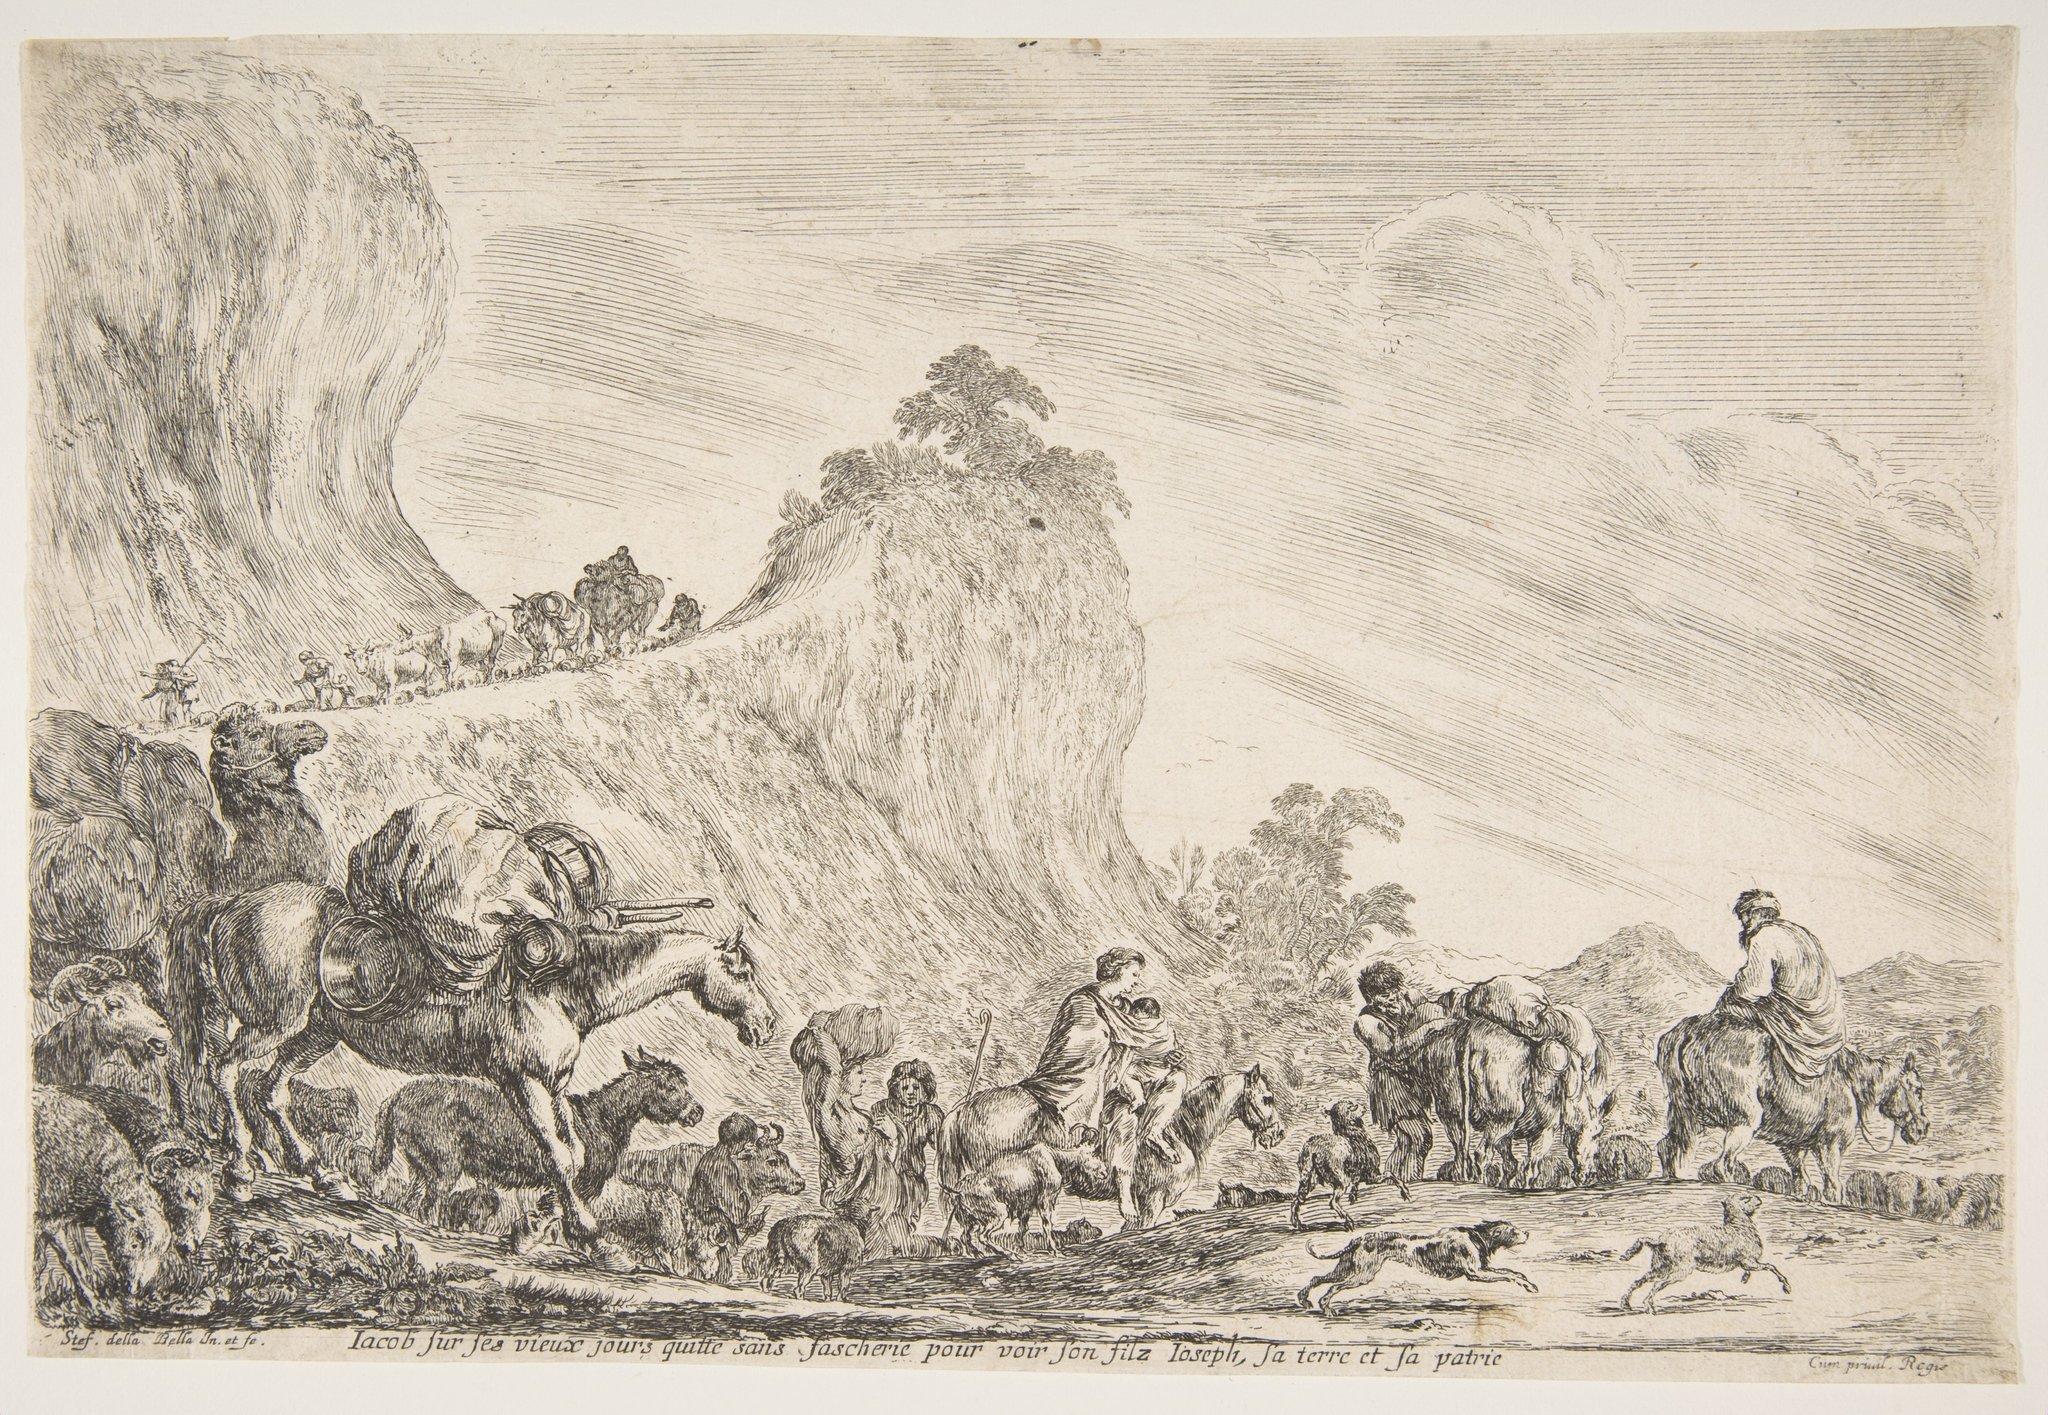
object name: print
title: The Voyage of Jacob in Egypt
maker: stefano della bella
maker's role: artist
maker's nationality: italian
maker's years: 1610-1664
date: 1647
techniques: etching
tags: men,dogs,horses